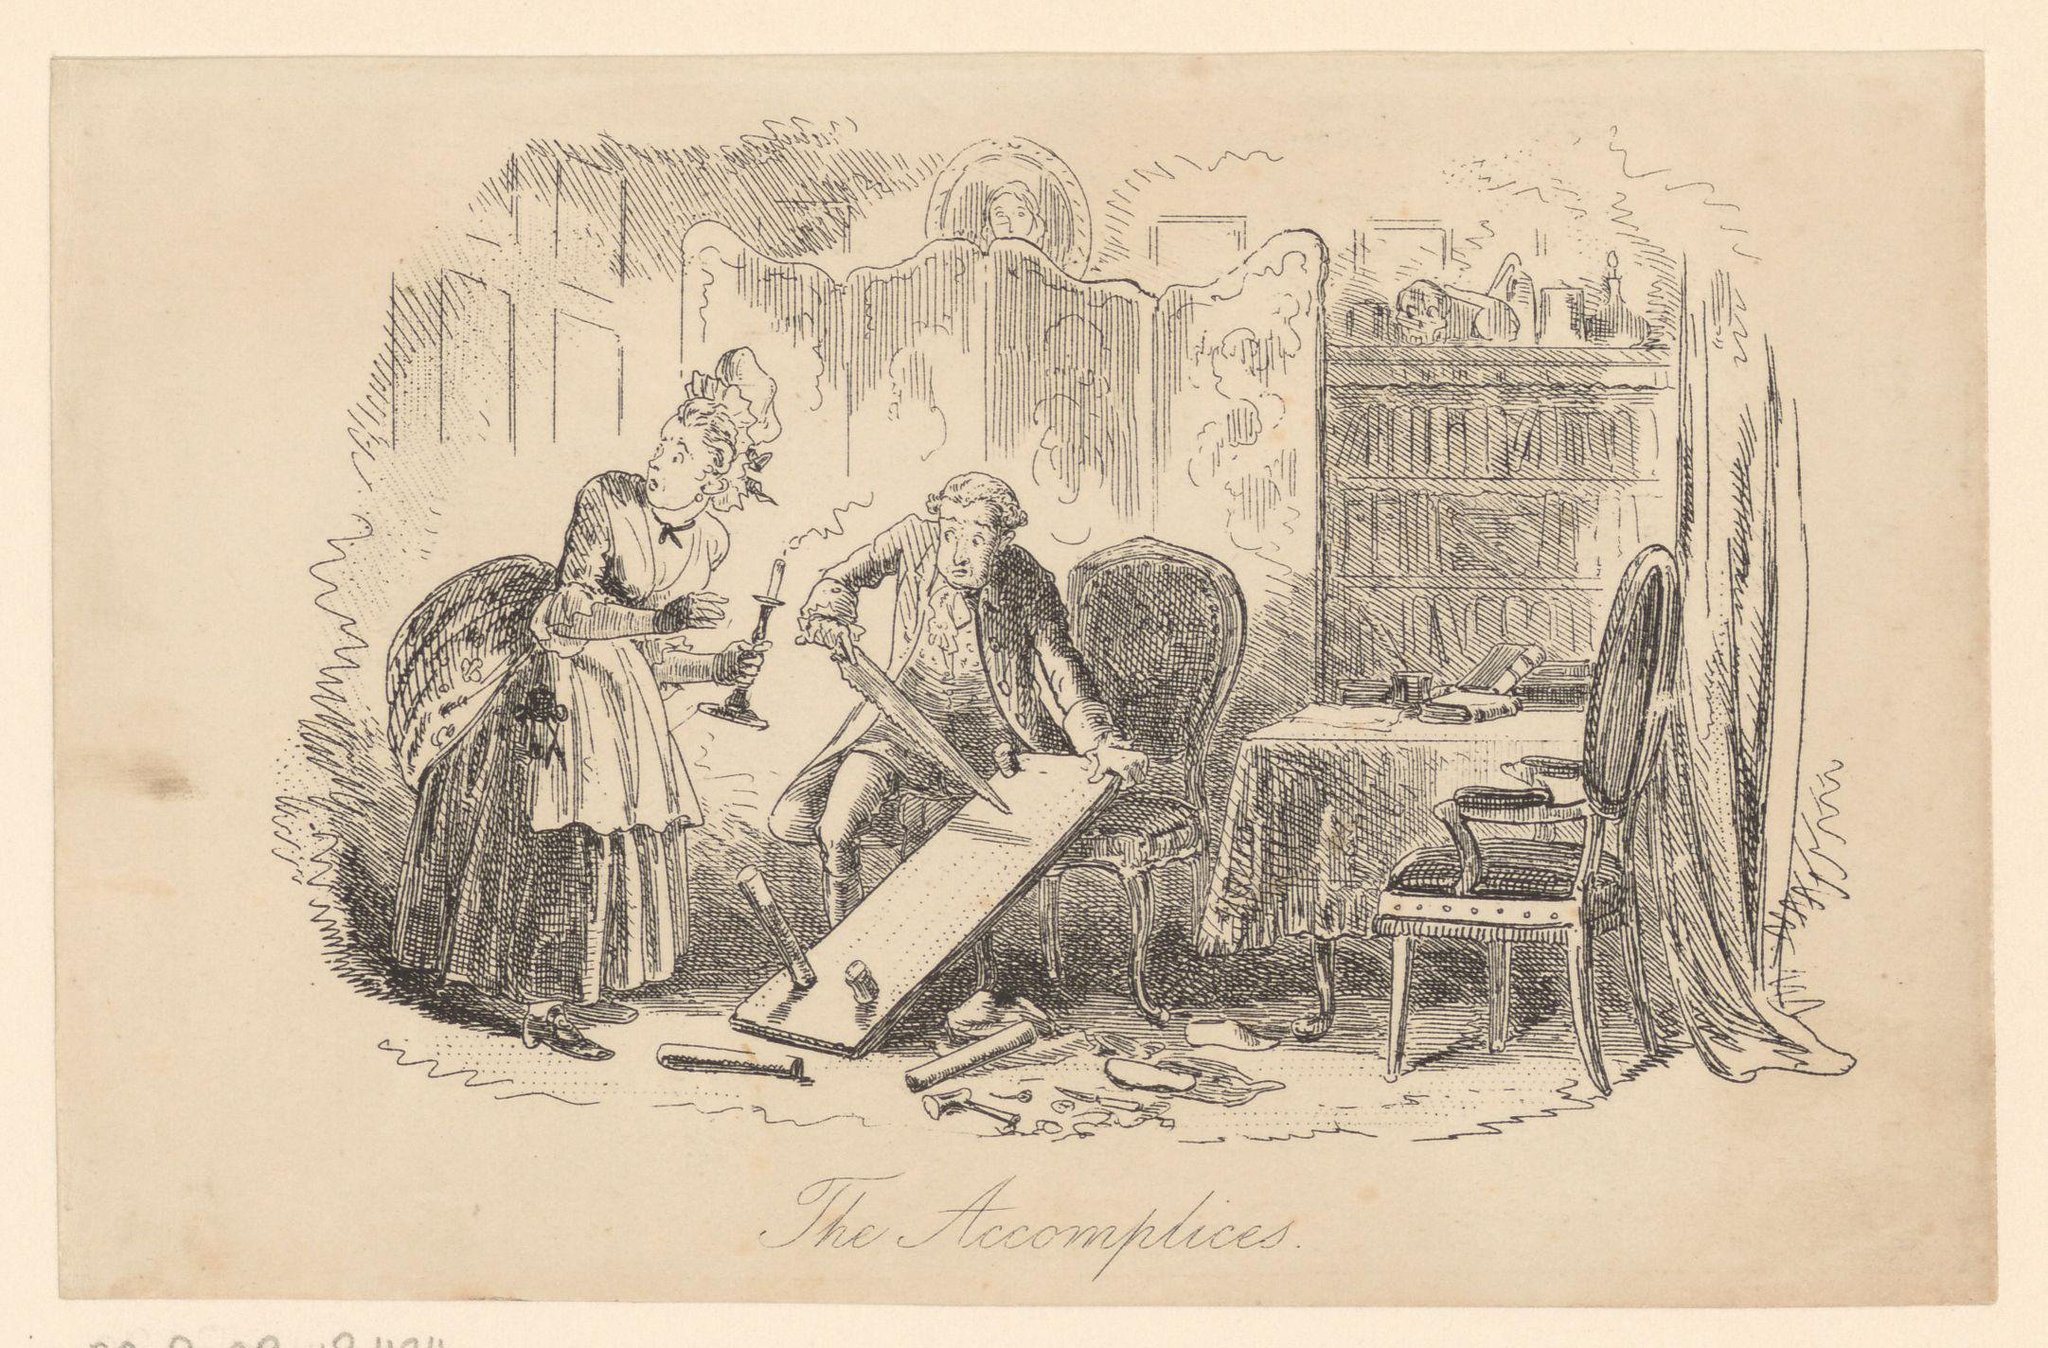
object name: book illustration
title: The Accomplices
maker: hablot knight browne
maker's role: print maker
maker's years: 1815-1882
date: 1859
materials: paper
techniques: etching, roulette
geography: london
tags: alarm, fright; 'spavento', 'terrore' (ripa), table, candle, tools, aids, implements ~ crafts and industries: saw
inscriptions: collector's mark: Lugt 2228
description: Prent uit: Dickens, Charles. A Tale of Two Cities. Londen: Chapman and Hall, 1859. Het boek werd van april tot november 1859 eerst in delen uitgegeven.